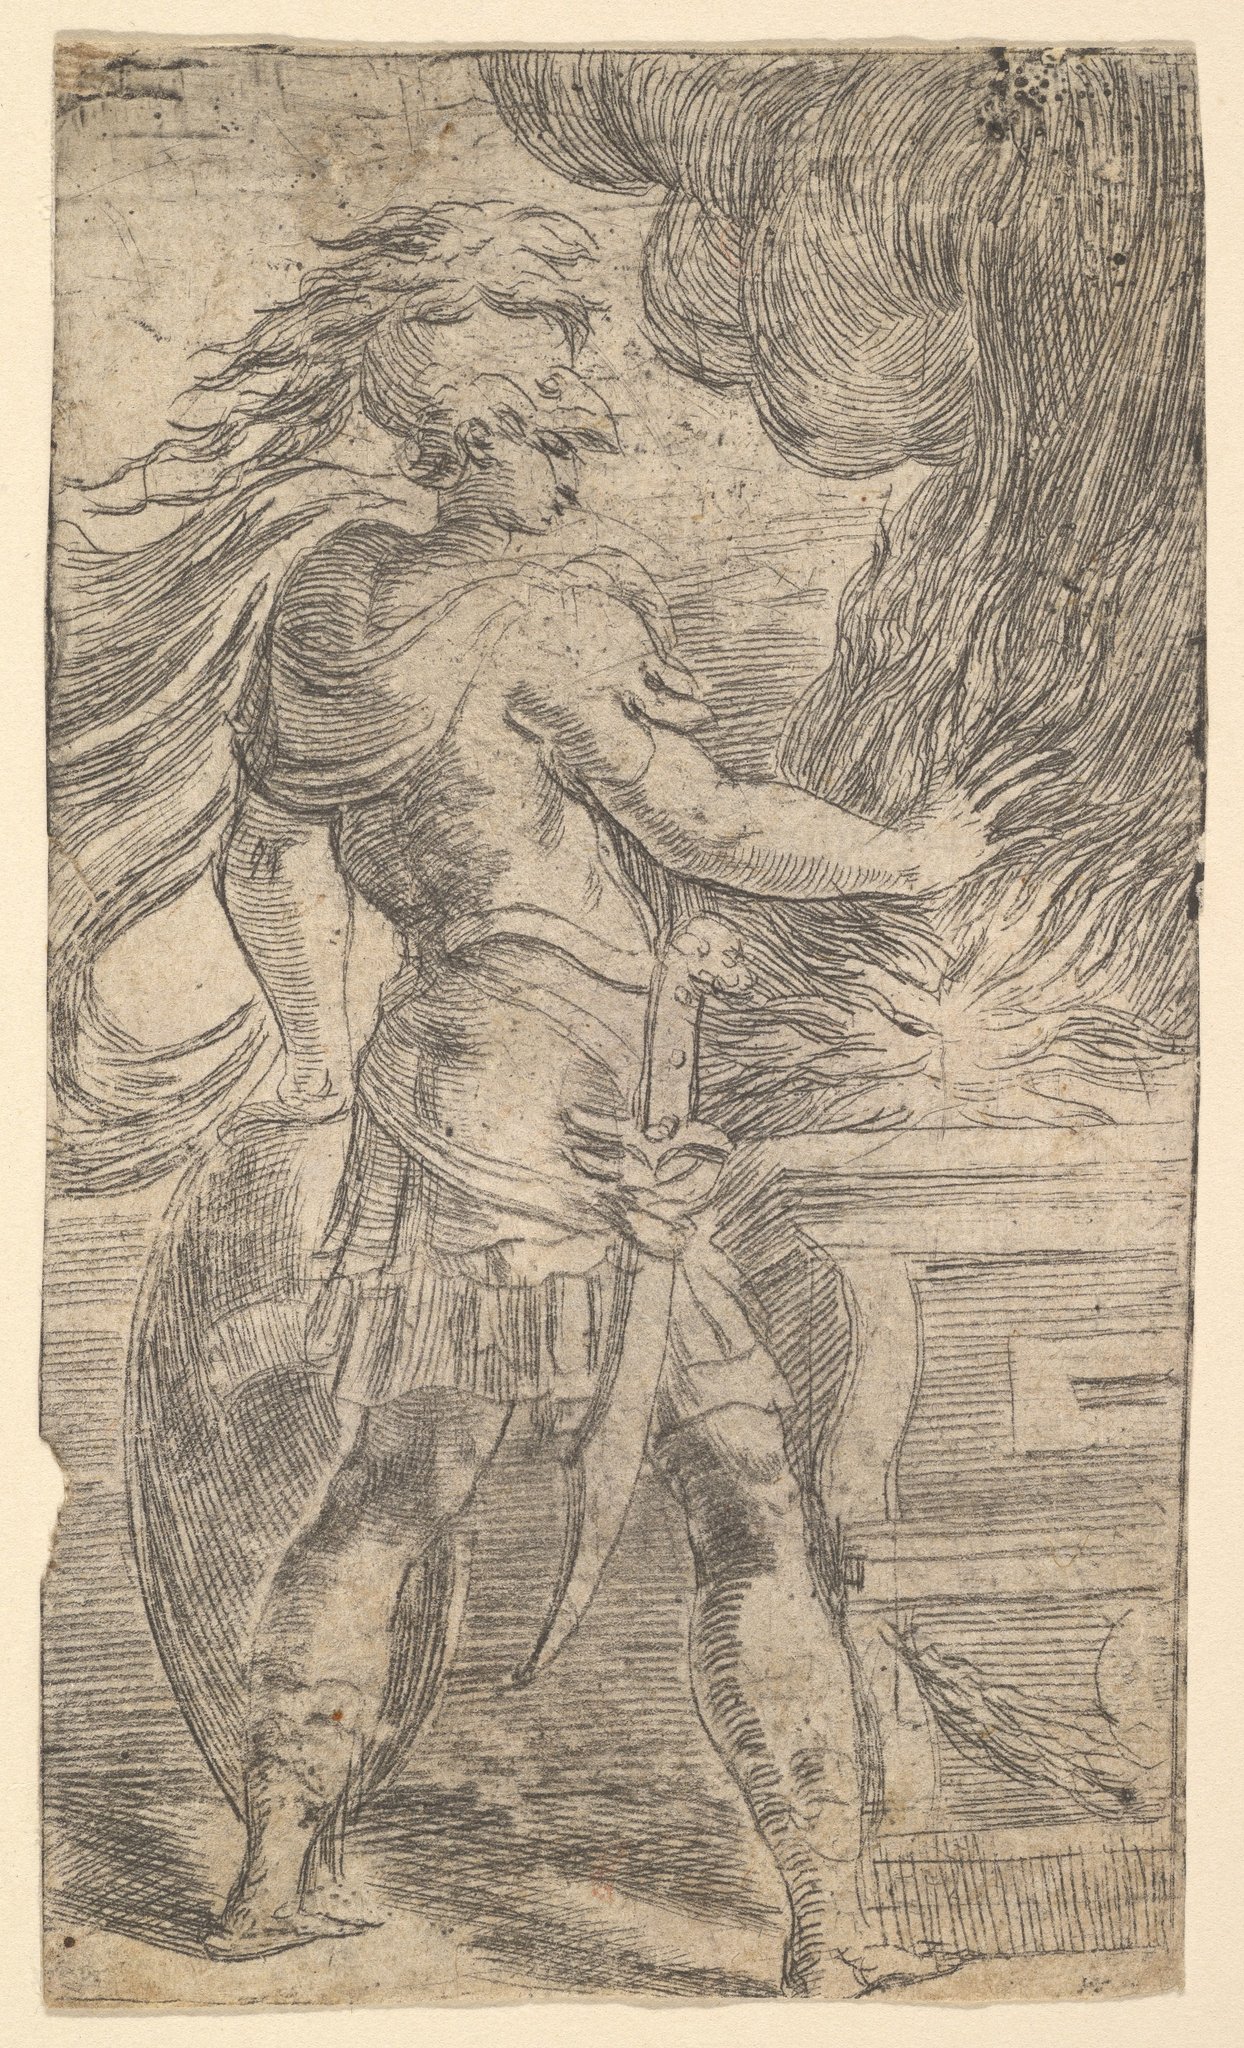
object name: print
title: Mutius Scaevola placing his hand in the flames (left half of a composition, the right half of which shows a woman extending her right arm towards an altar)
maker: andrea schiavone (andrea meldola)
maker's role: artist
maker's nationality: italian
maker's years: 1510-1563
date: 1540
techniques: etching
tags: swords,men,fire